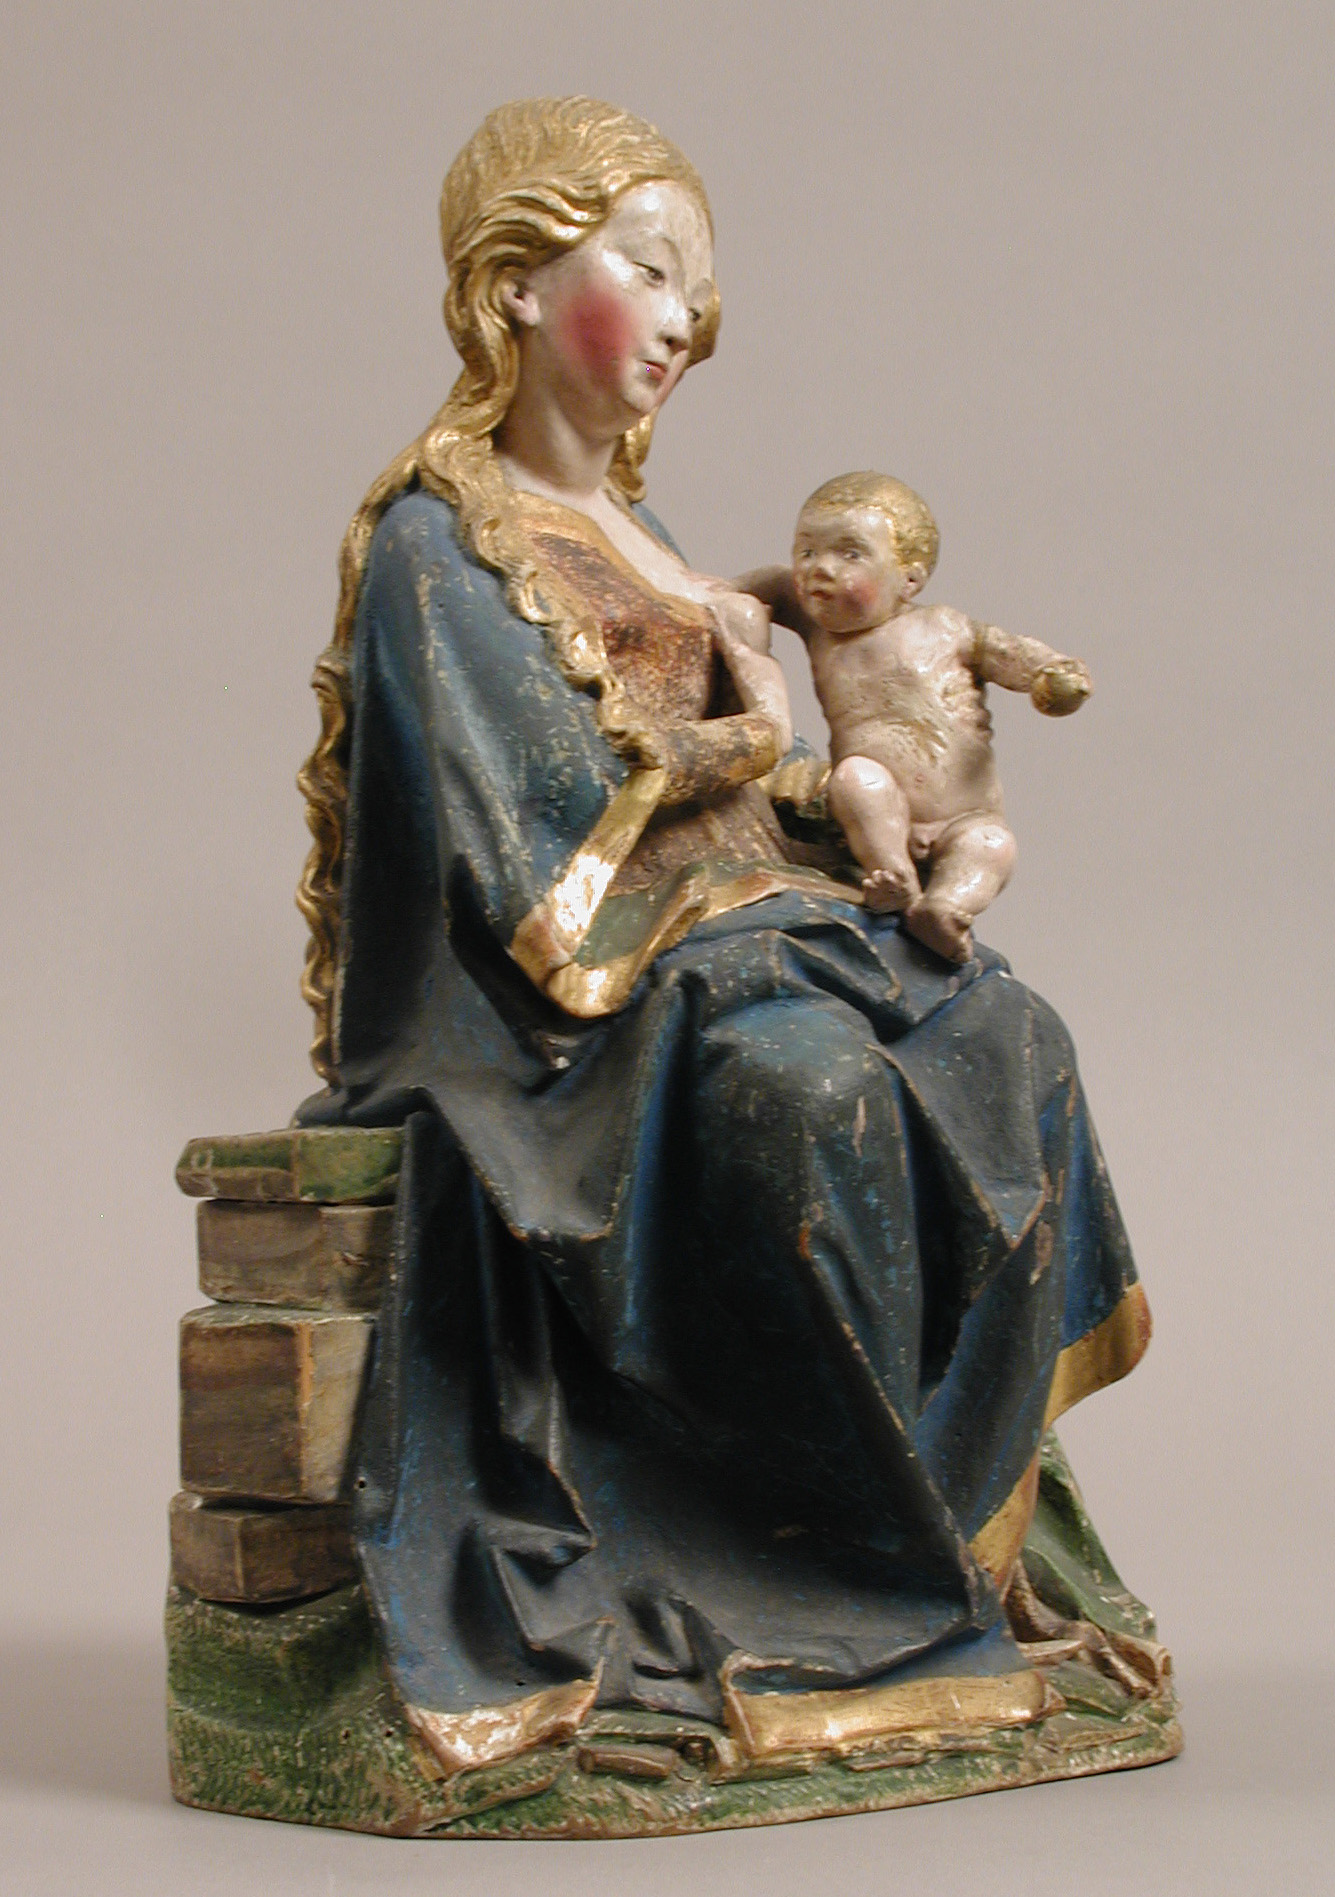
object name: statuette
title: Enthroned Virgin with Nursing Child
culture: german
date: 1467-1500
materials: wood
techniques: gilding, painting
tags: madonna and child,nursing